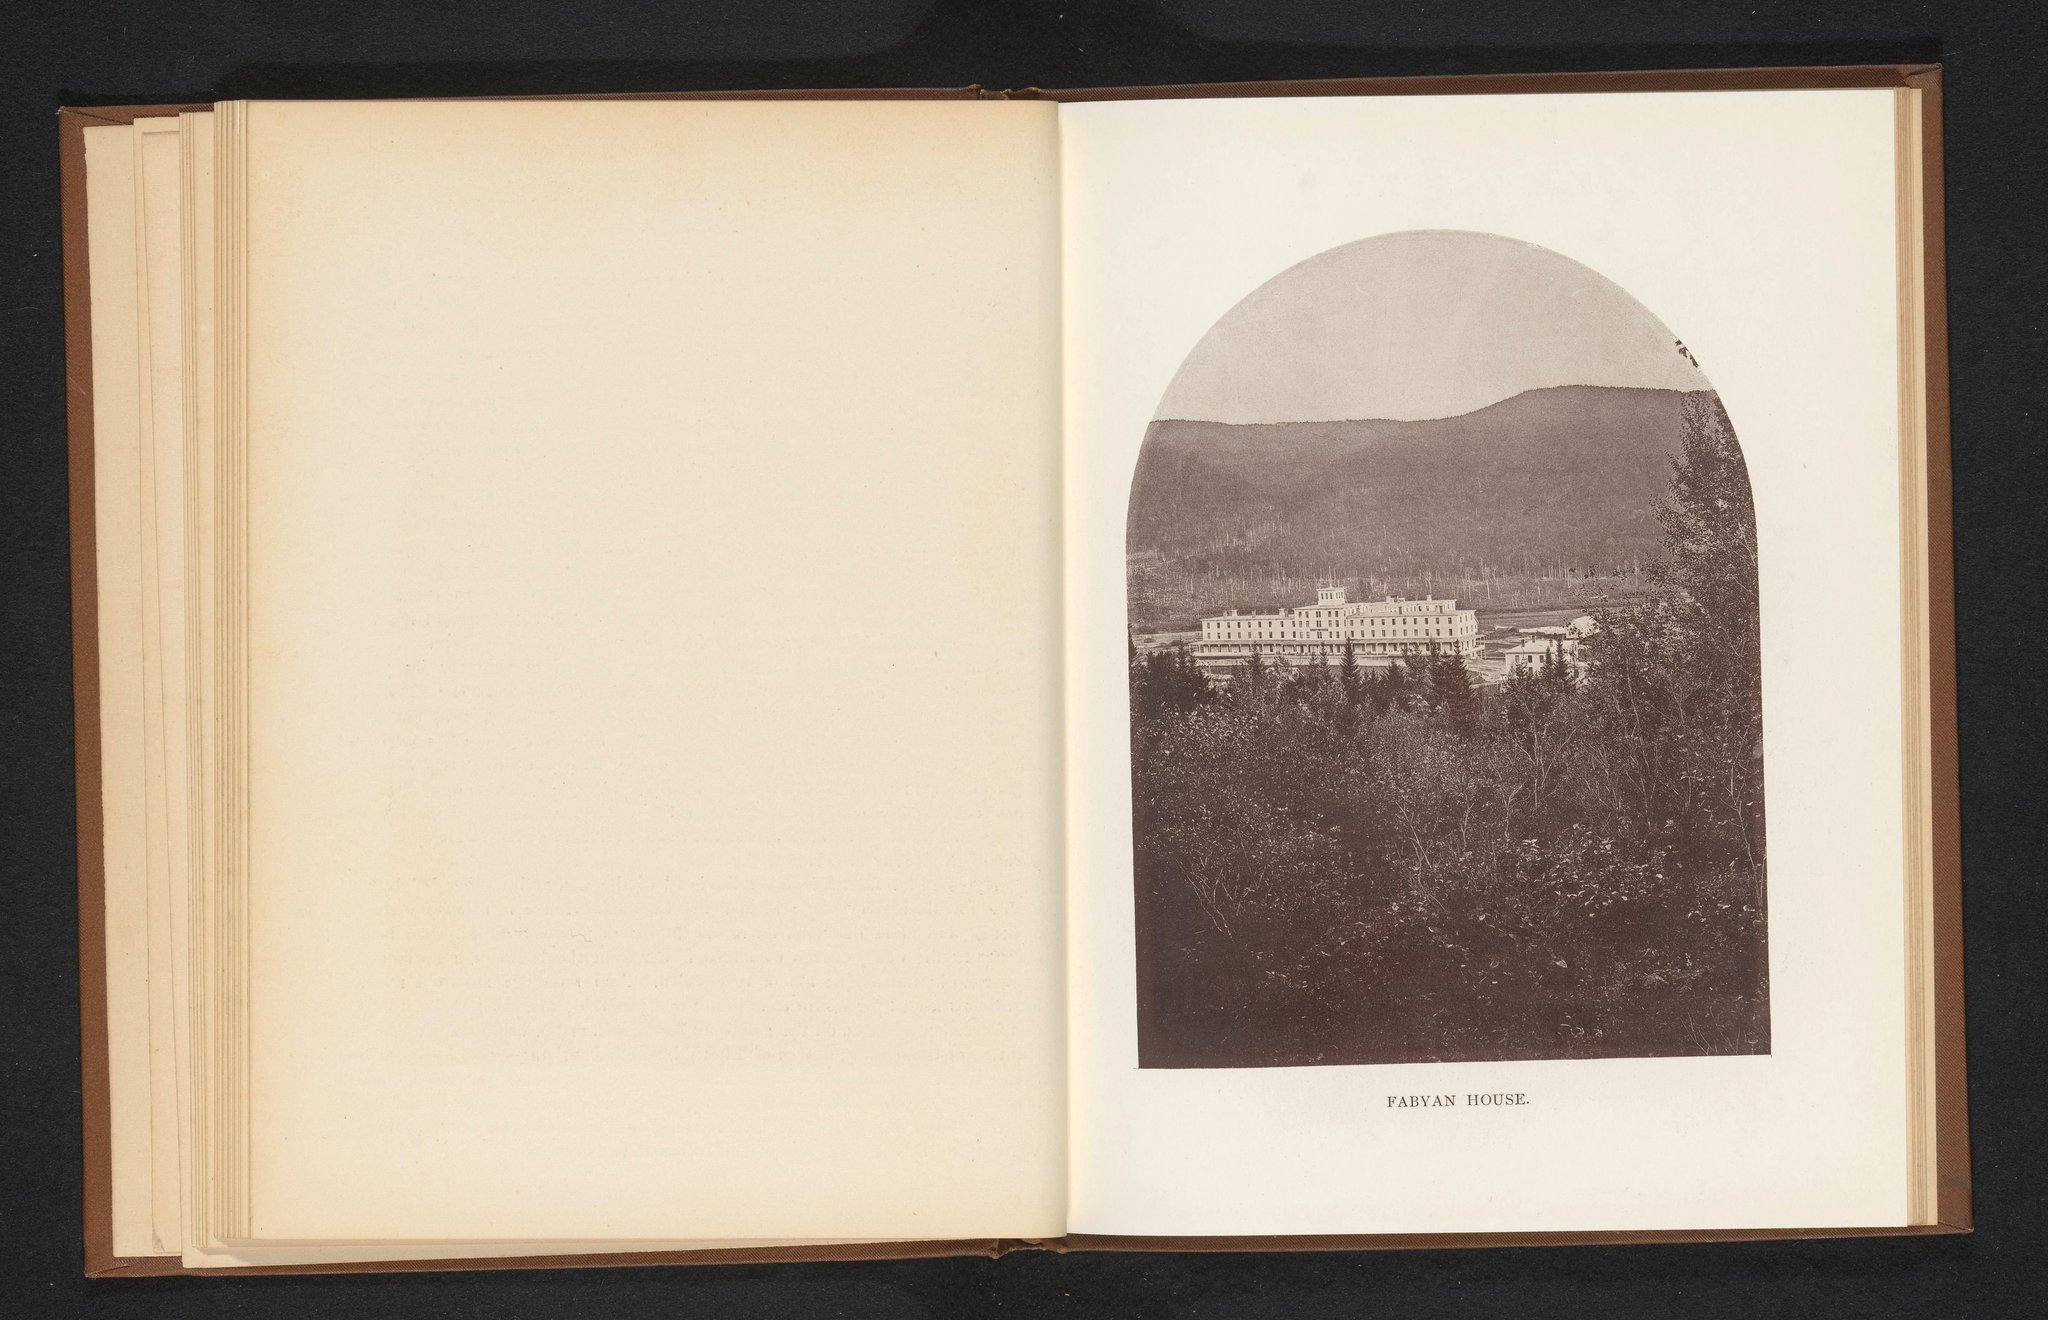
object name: photomechanical print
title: Fabyan House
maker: Anonymous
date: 1874-1879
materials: paper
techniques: photograph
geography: white mountains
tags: hotel, hostelry, inn, mountains